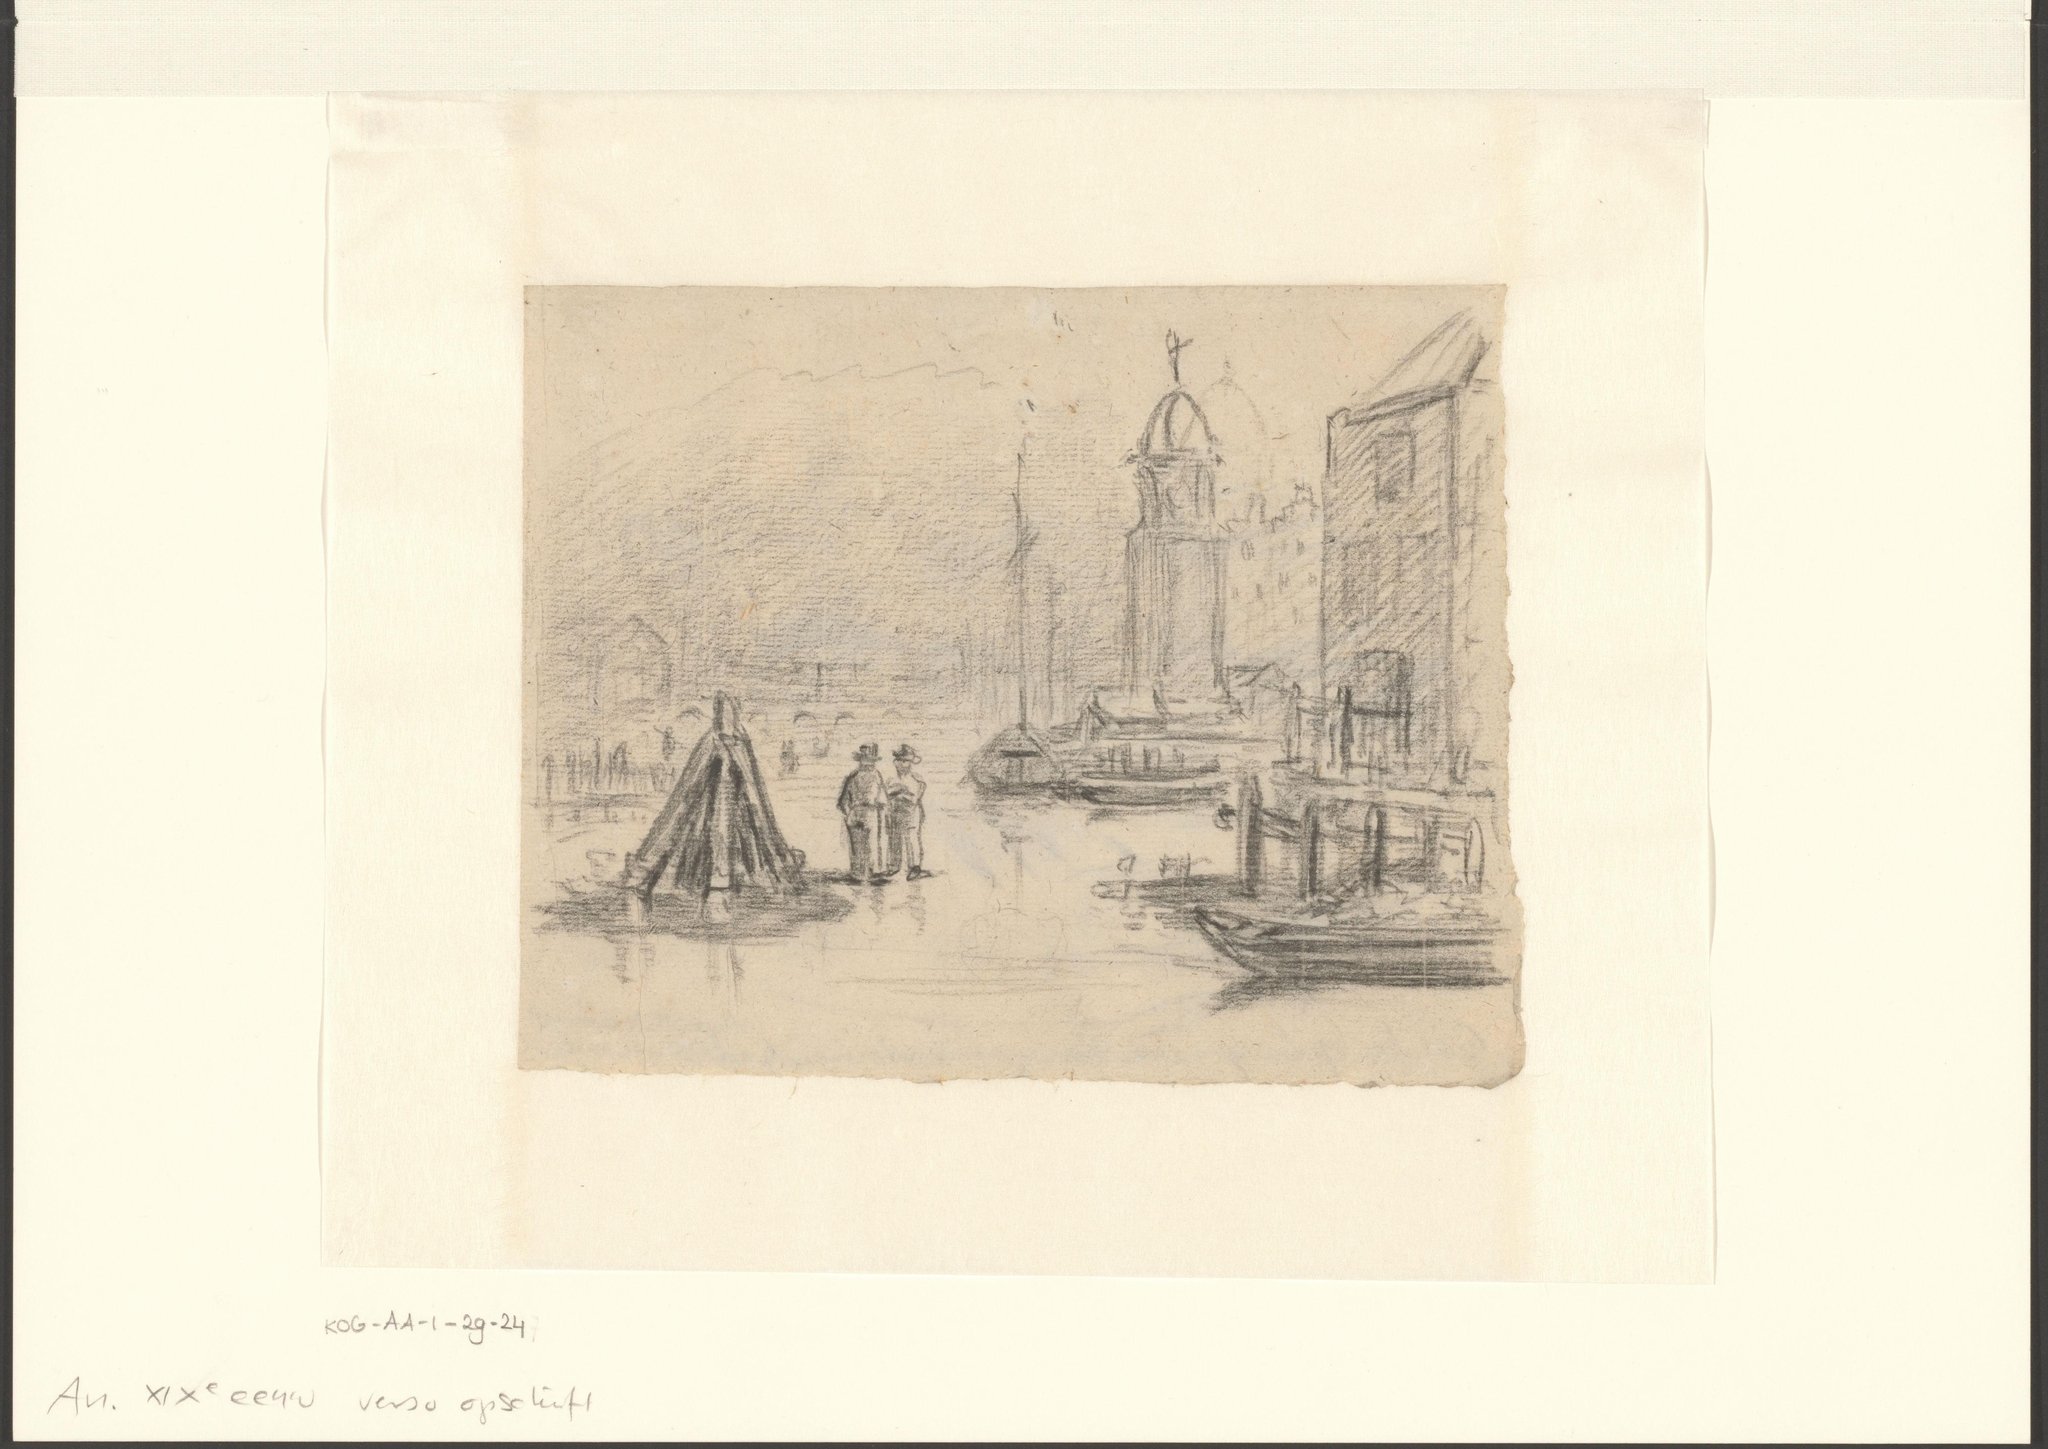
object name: drawing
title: Gezicht op de Haringpakkerstoren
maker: Anonymous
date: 1800-1899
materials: chalk, paper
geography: amsterdam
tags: tower, clock tower ~ monumental adornment, city-view in general; 'veduta', canal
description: Onderwerpsrubriek binnen de Atlas Amsterdam: Haringpakkerstoren.